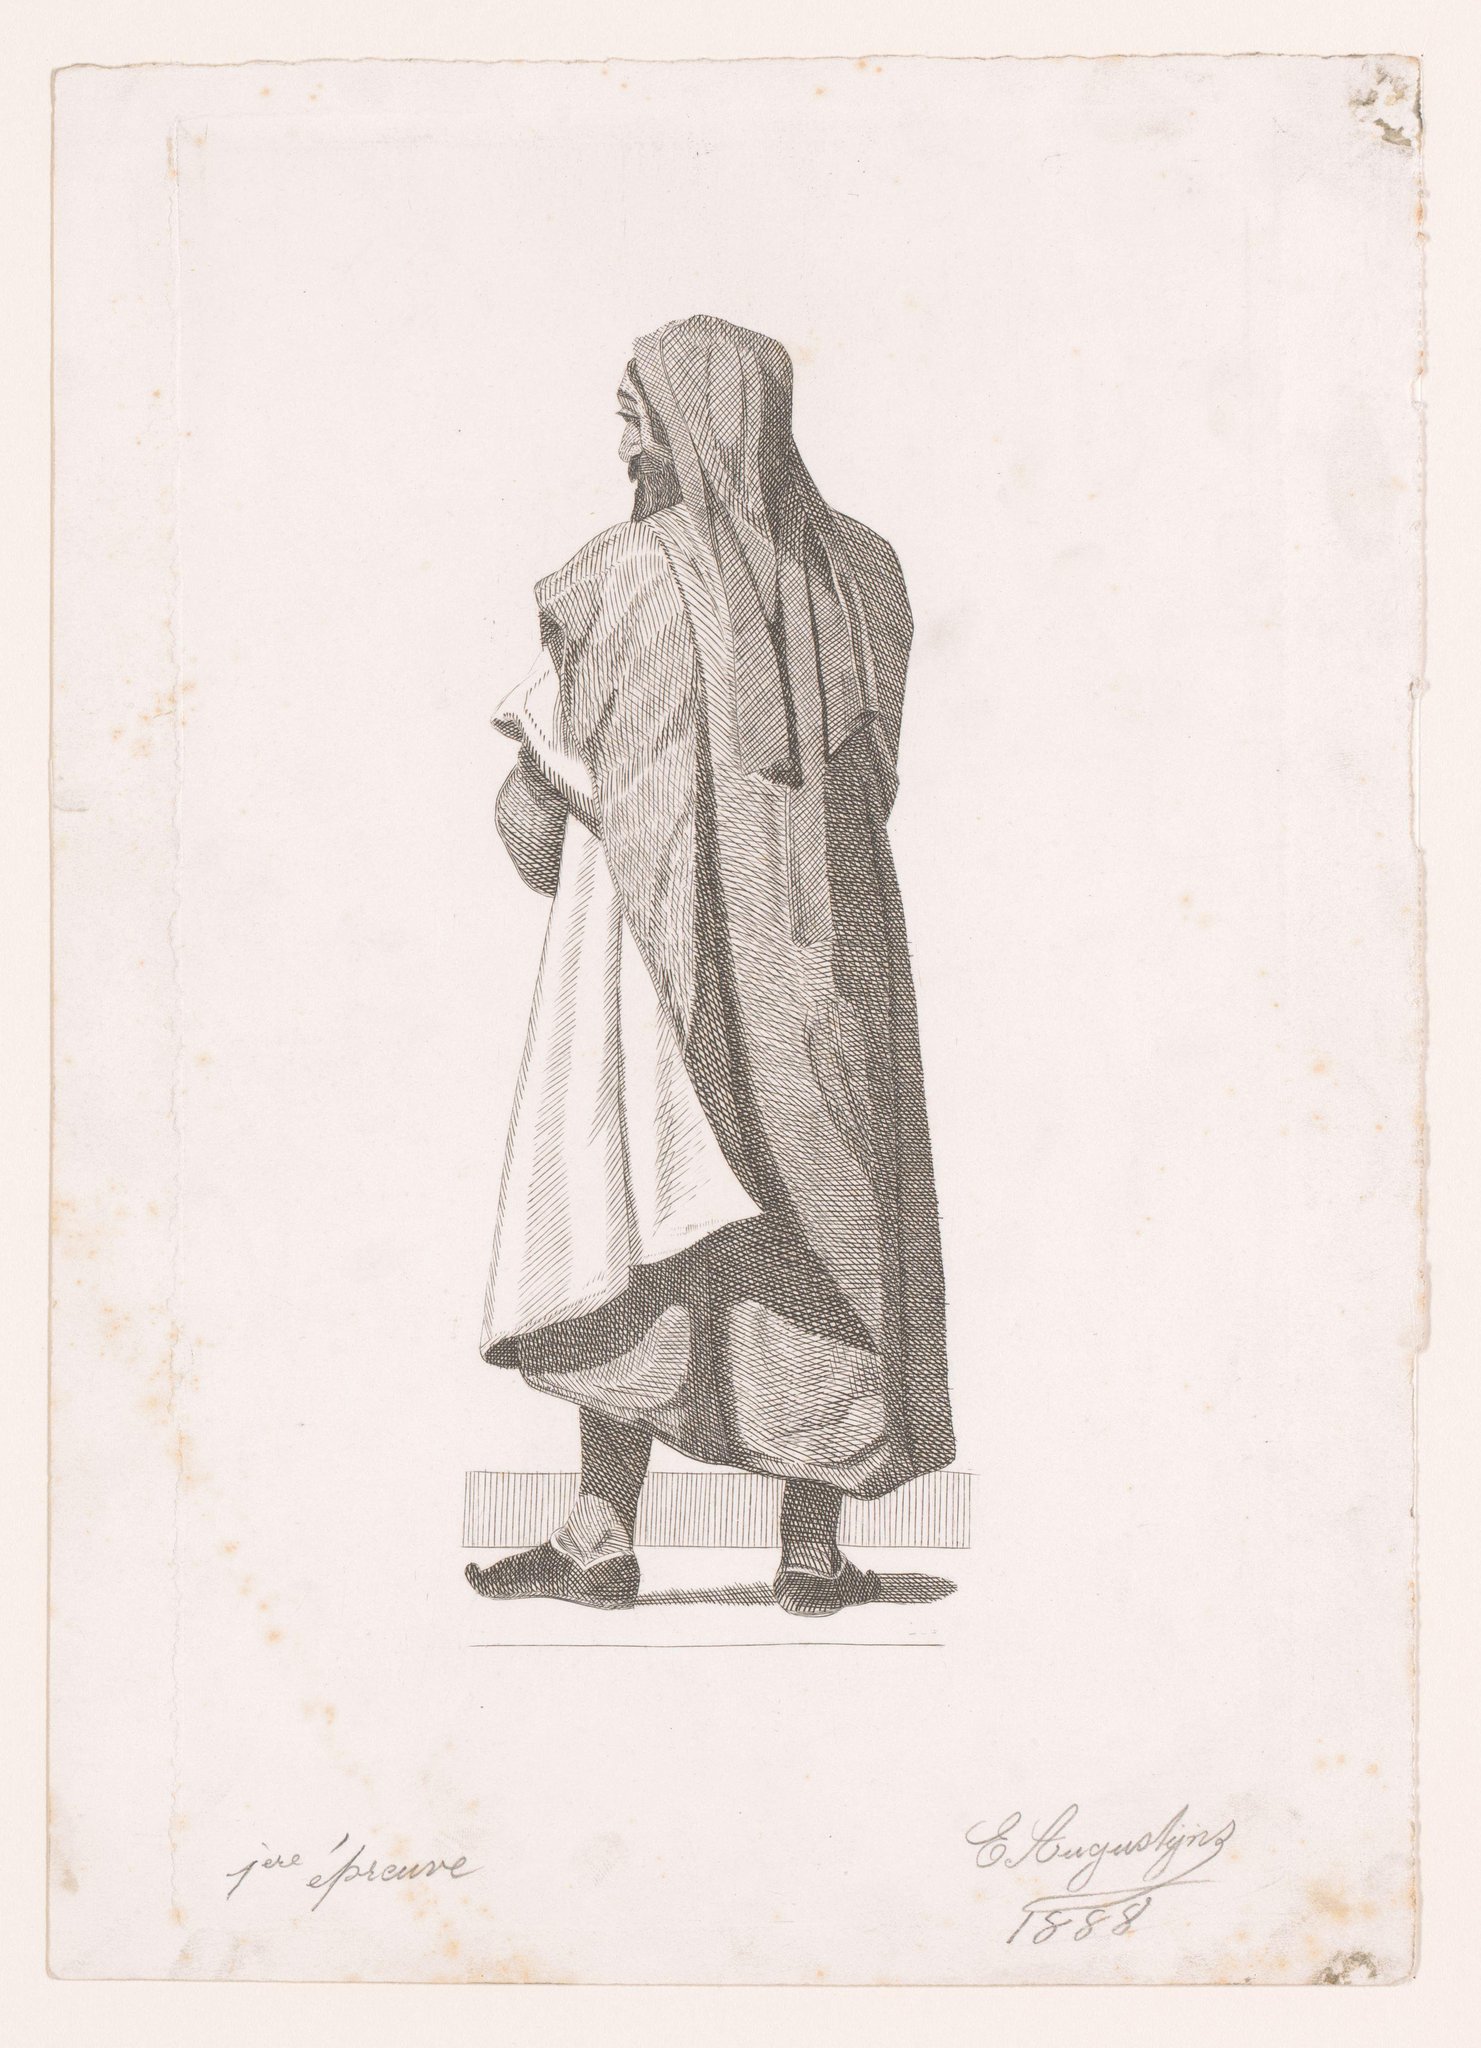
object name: print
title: Staande man in middeleeuwse kleding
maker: eduard augustyns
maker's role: print maker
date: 1888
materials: paper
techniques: engraving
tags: standing figure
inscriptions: collector's mark: Lugt 2228